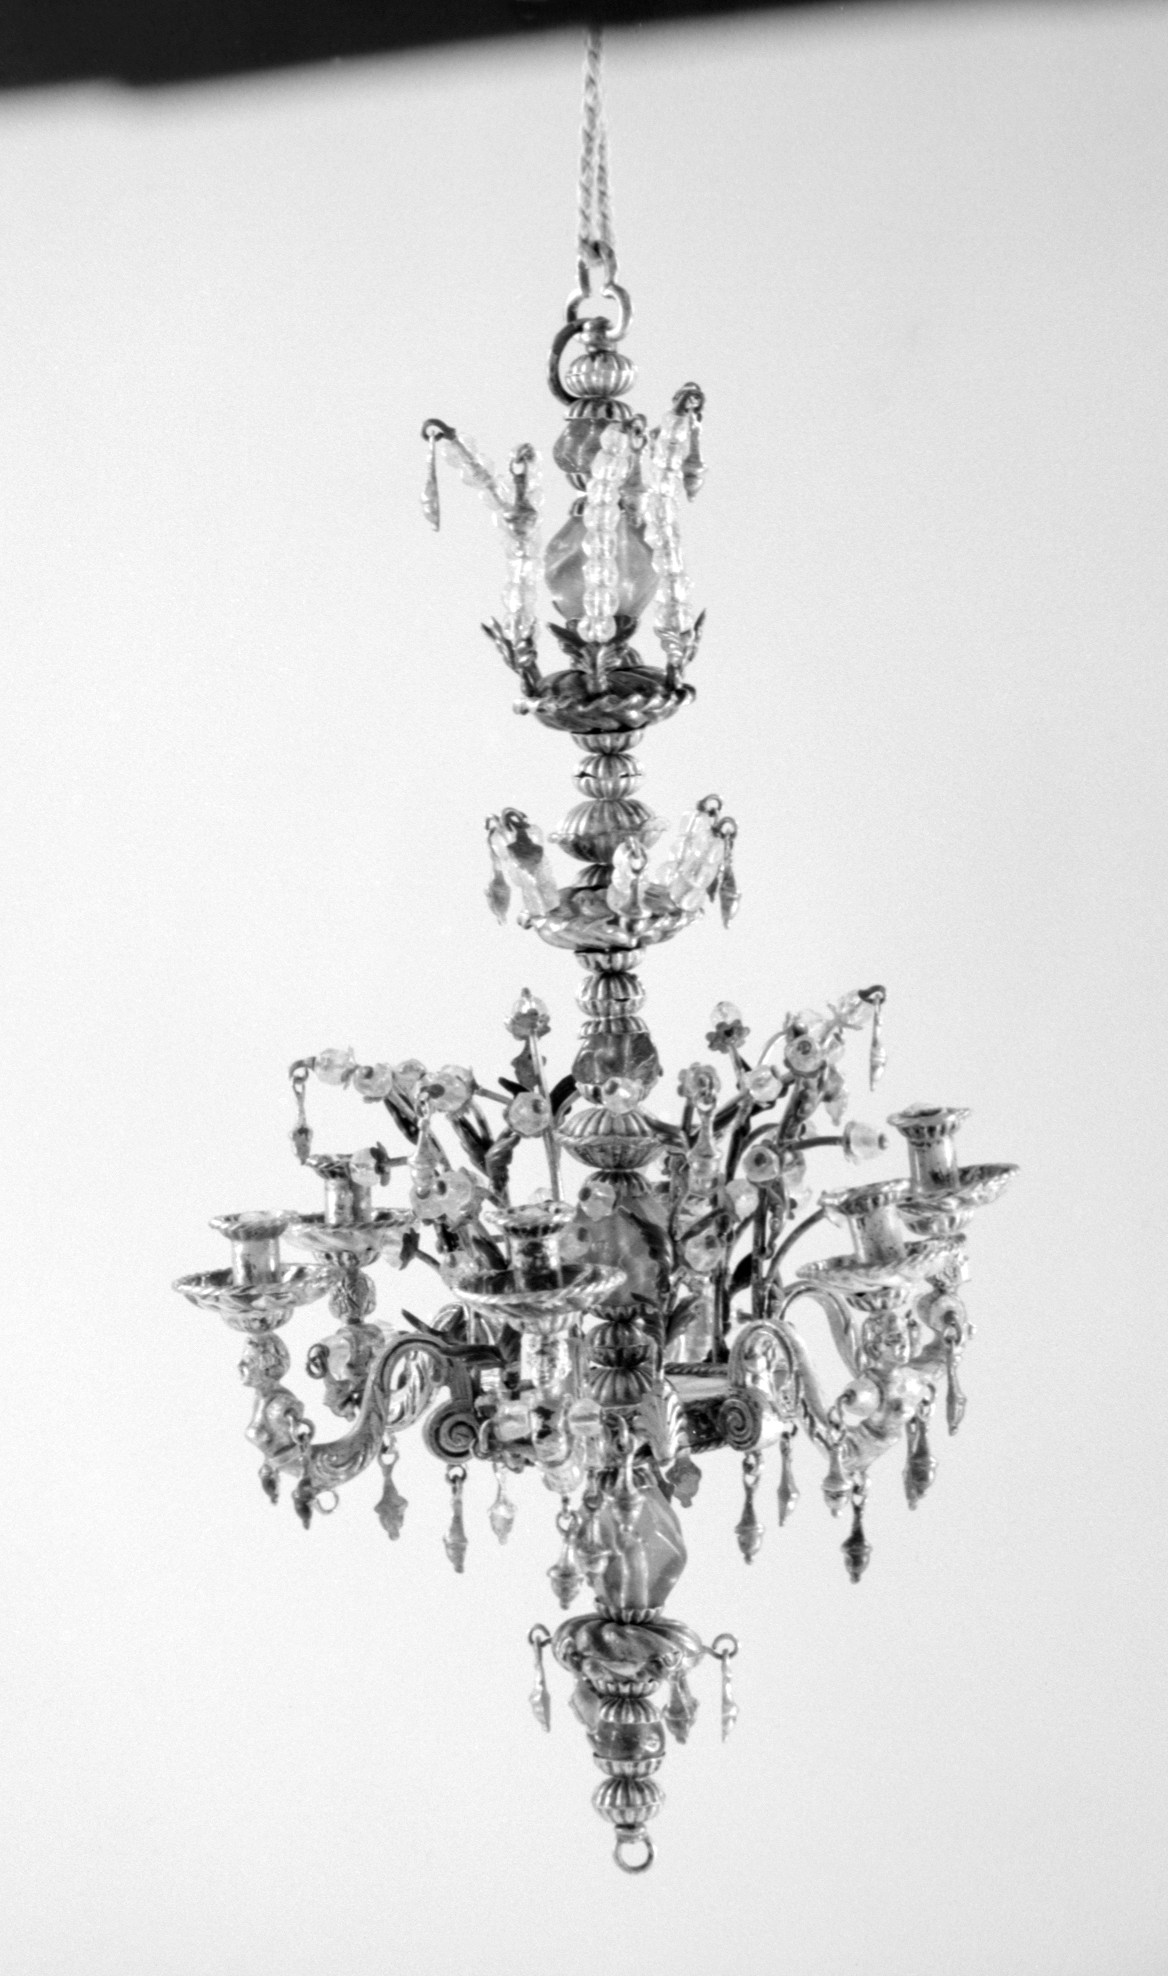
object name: chandelier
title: Miniature chandelier (one of a pair)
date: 1701-1733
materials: glass, gold, quartz